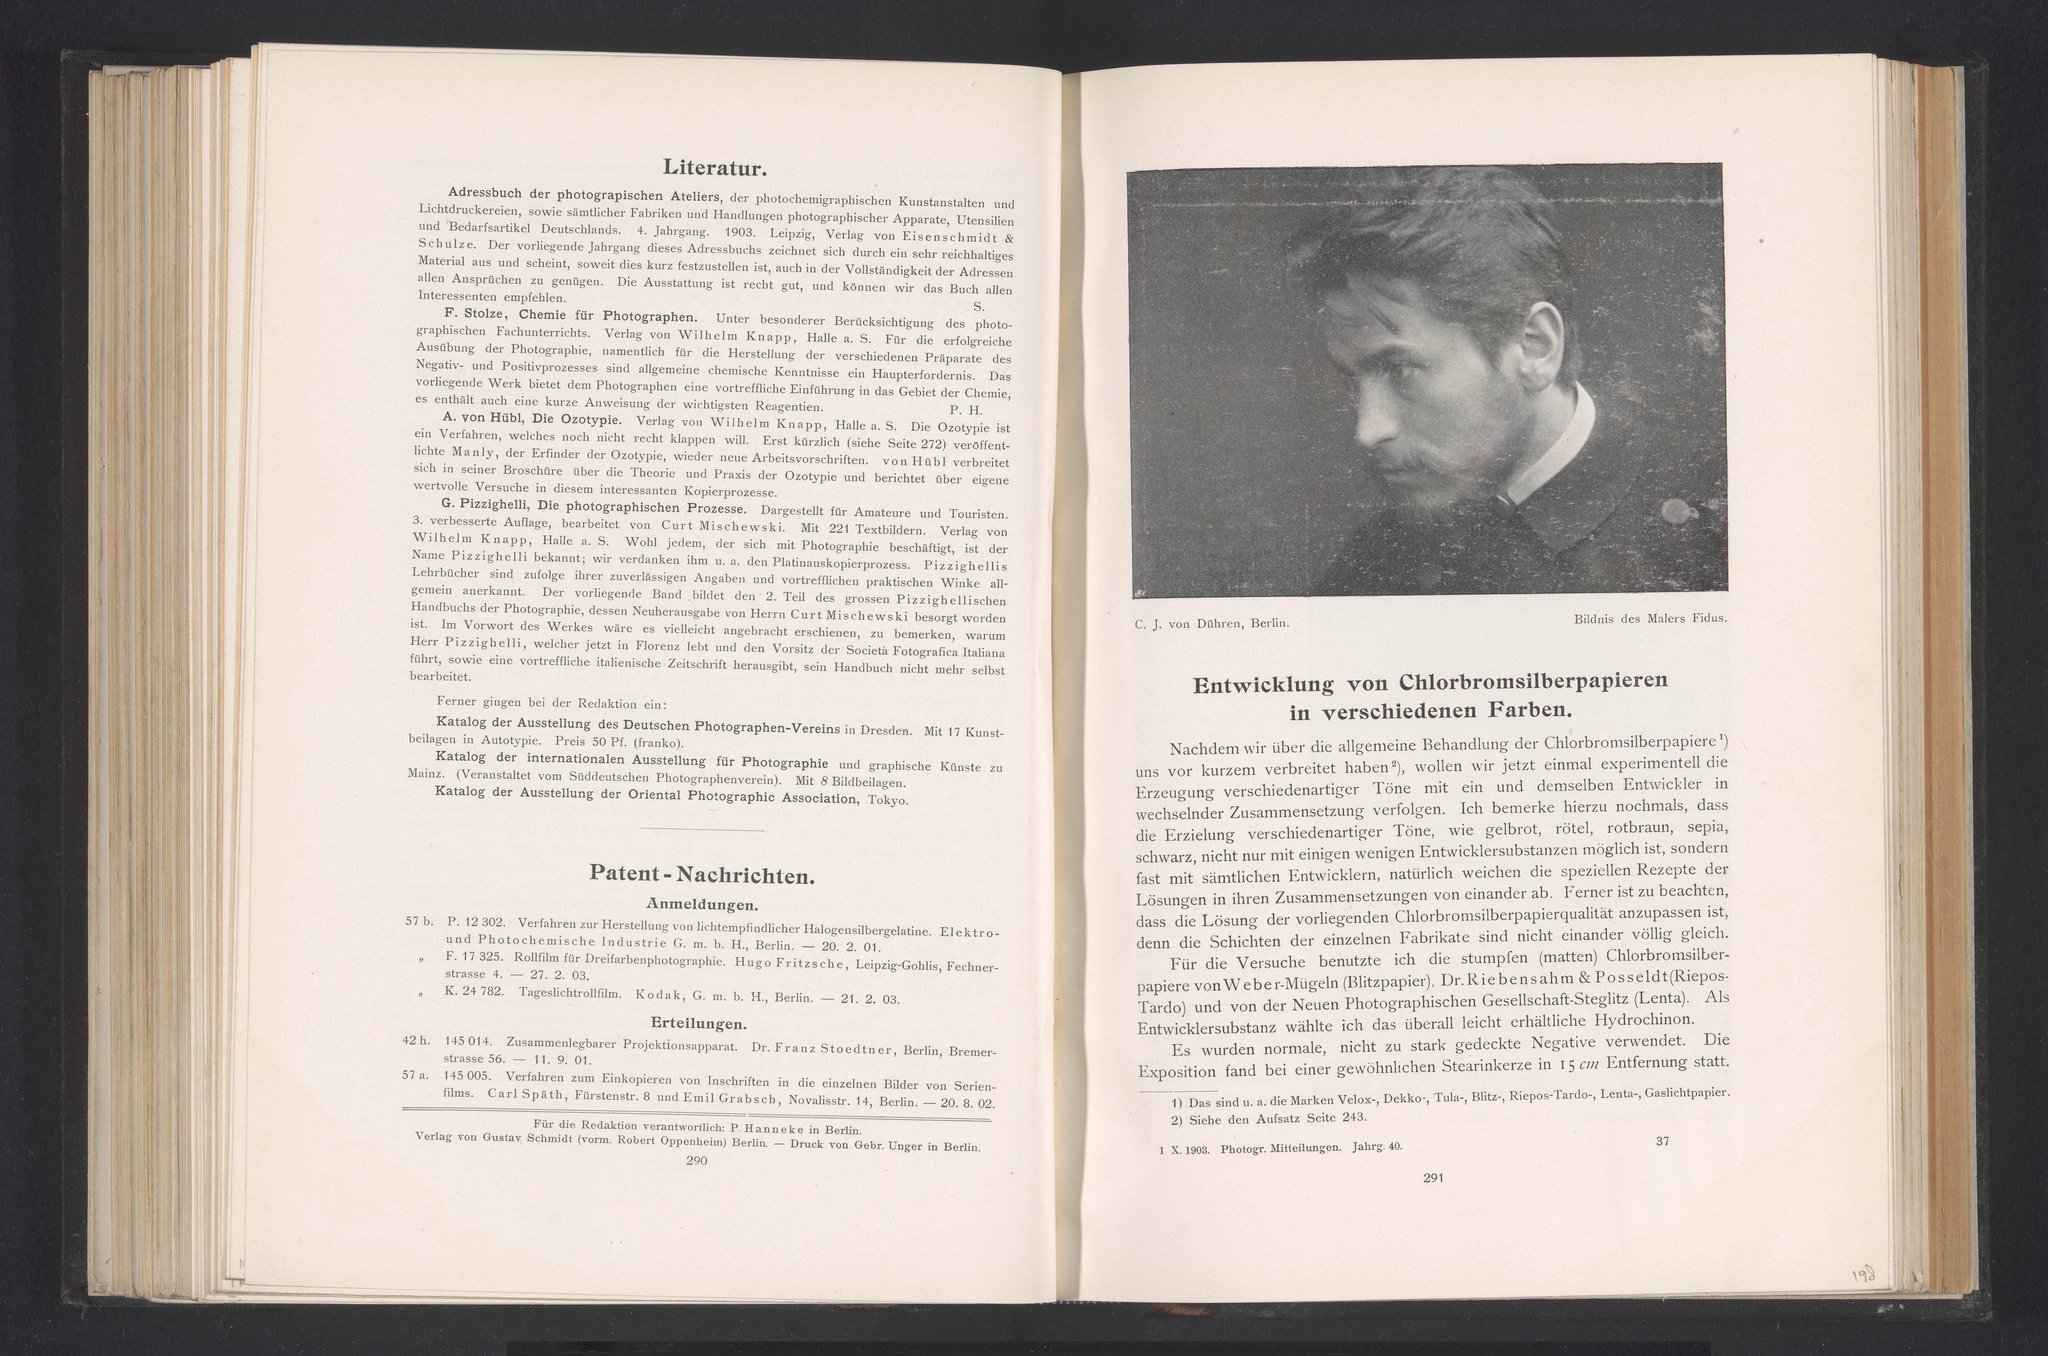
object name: photomechanical print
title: Portret van Fidus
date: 1898-1903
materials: paper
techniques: autotype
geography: berlin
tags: berlin, painter, draughtsman, publisher, sculptor, historical persons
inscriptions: monogram: ‘BX’